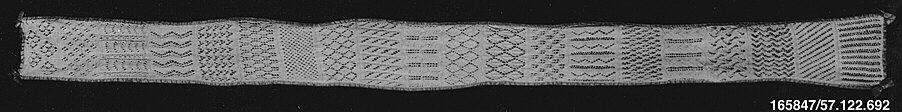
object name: sampler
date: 1801-1900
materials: lace, wool